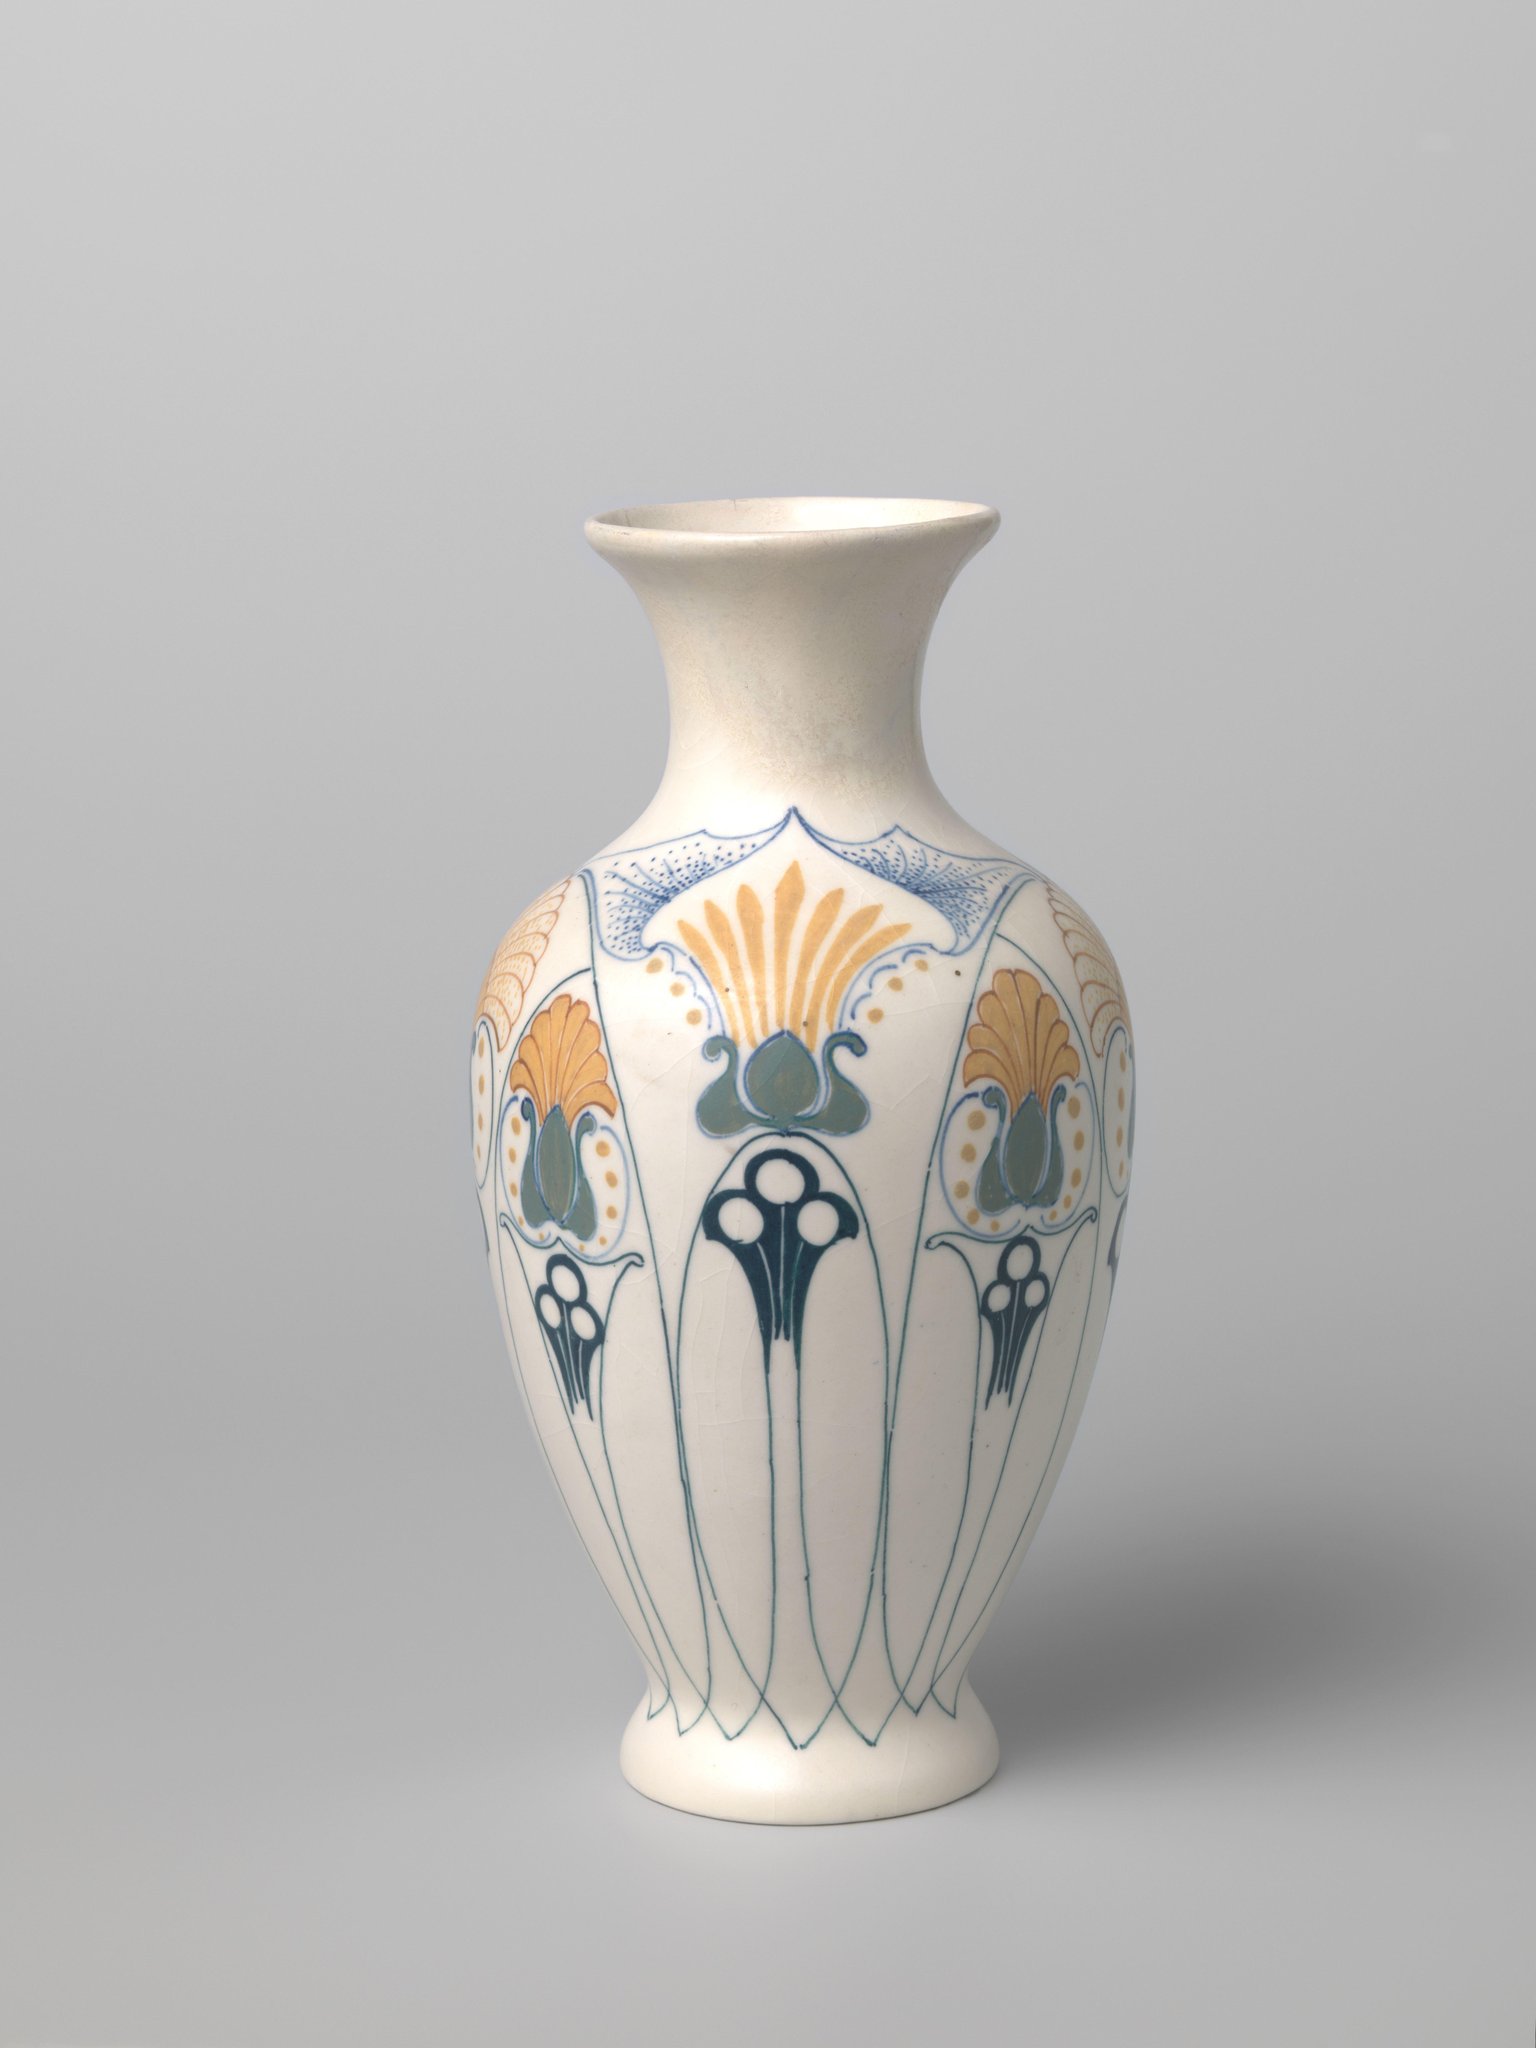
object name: vase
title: Vaas van aardewerk, versierd met palmetmotieven in blauw, groen, geel en oranje.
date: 1910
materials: earthenware, glaze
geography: arnhem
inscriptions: mark: ‘haan, waaromheen de letters ARNHEM binnen een veelhoek en ARNHEM en 38 met een doorsneden Z in blauw.’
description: Vaas van aardewerk, versierd met palmetmotieven in blauw, groen, geel en oranje.